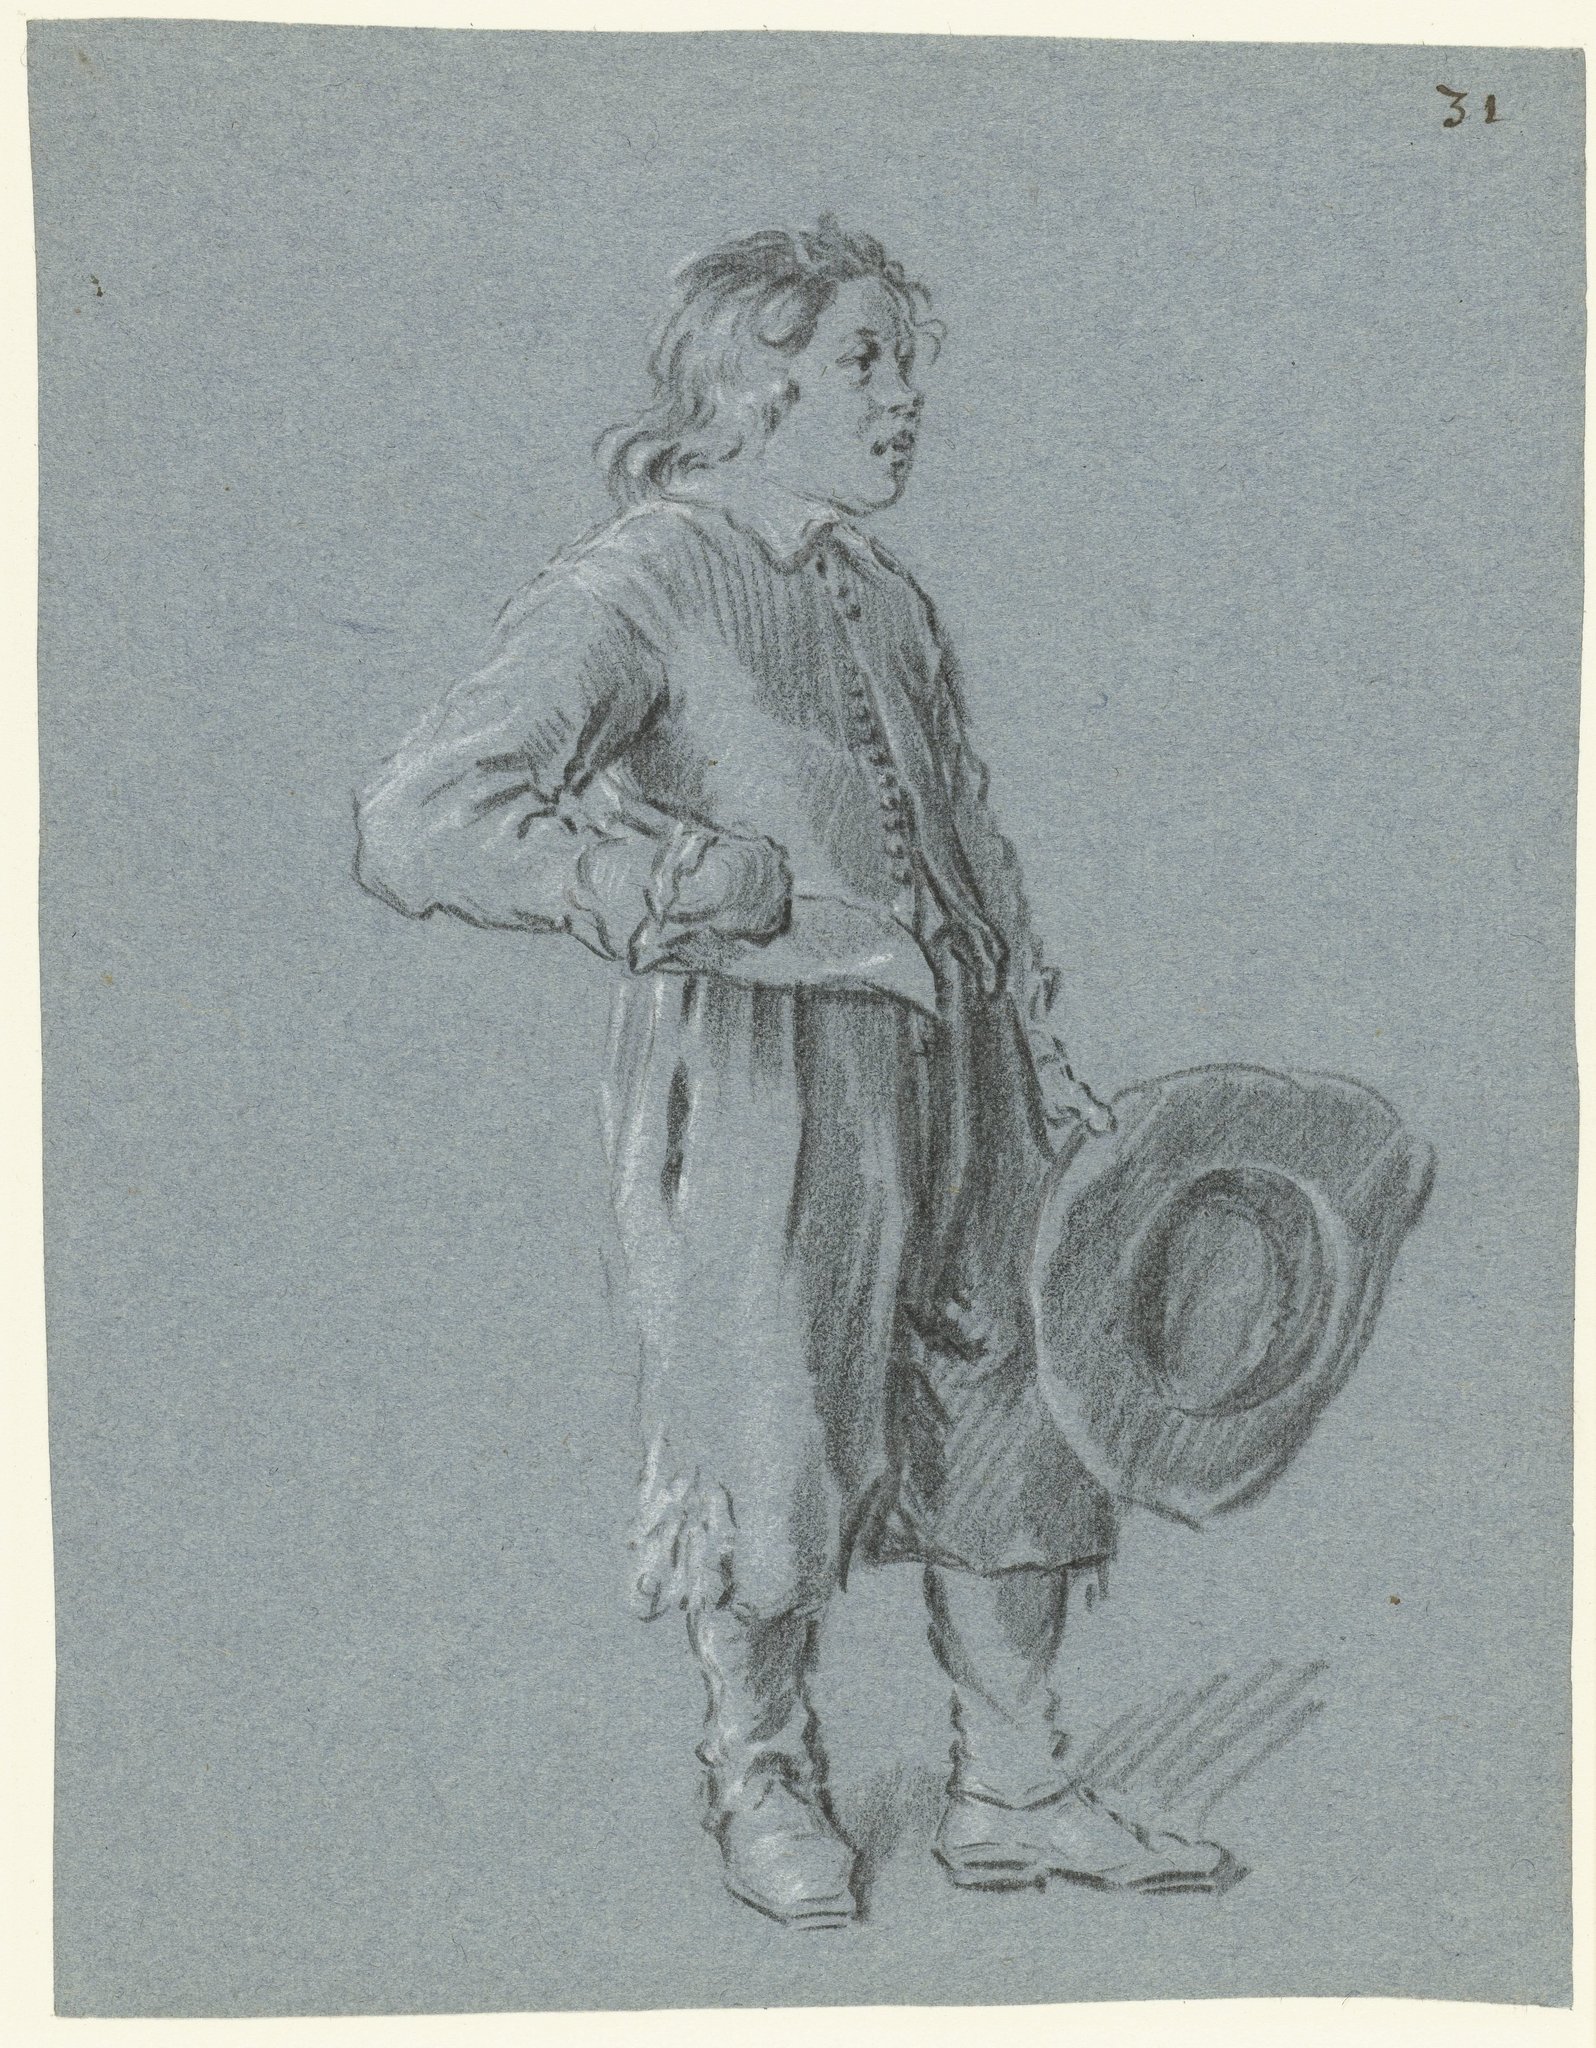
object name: drawing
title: Staand jongetje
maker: Anonymous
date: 1600-1699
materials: chalk, paper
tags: standing figure, boy (child between toddler and youth)